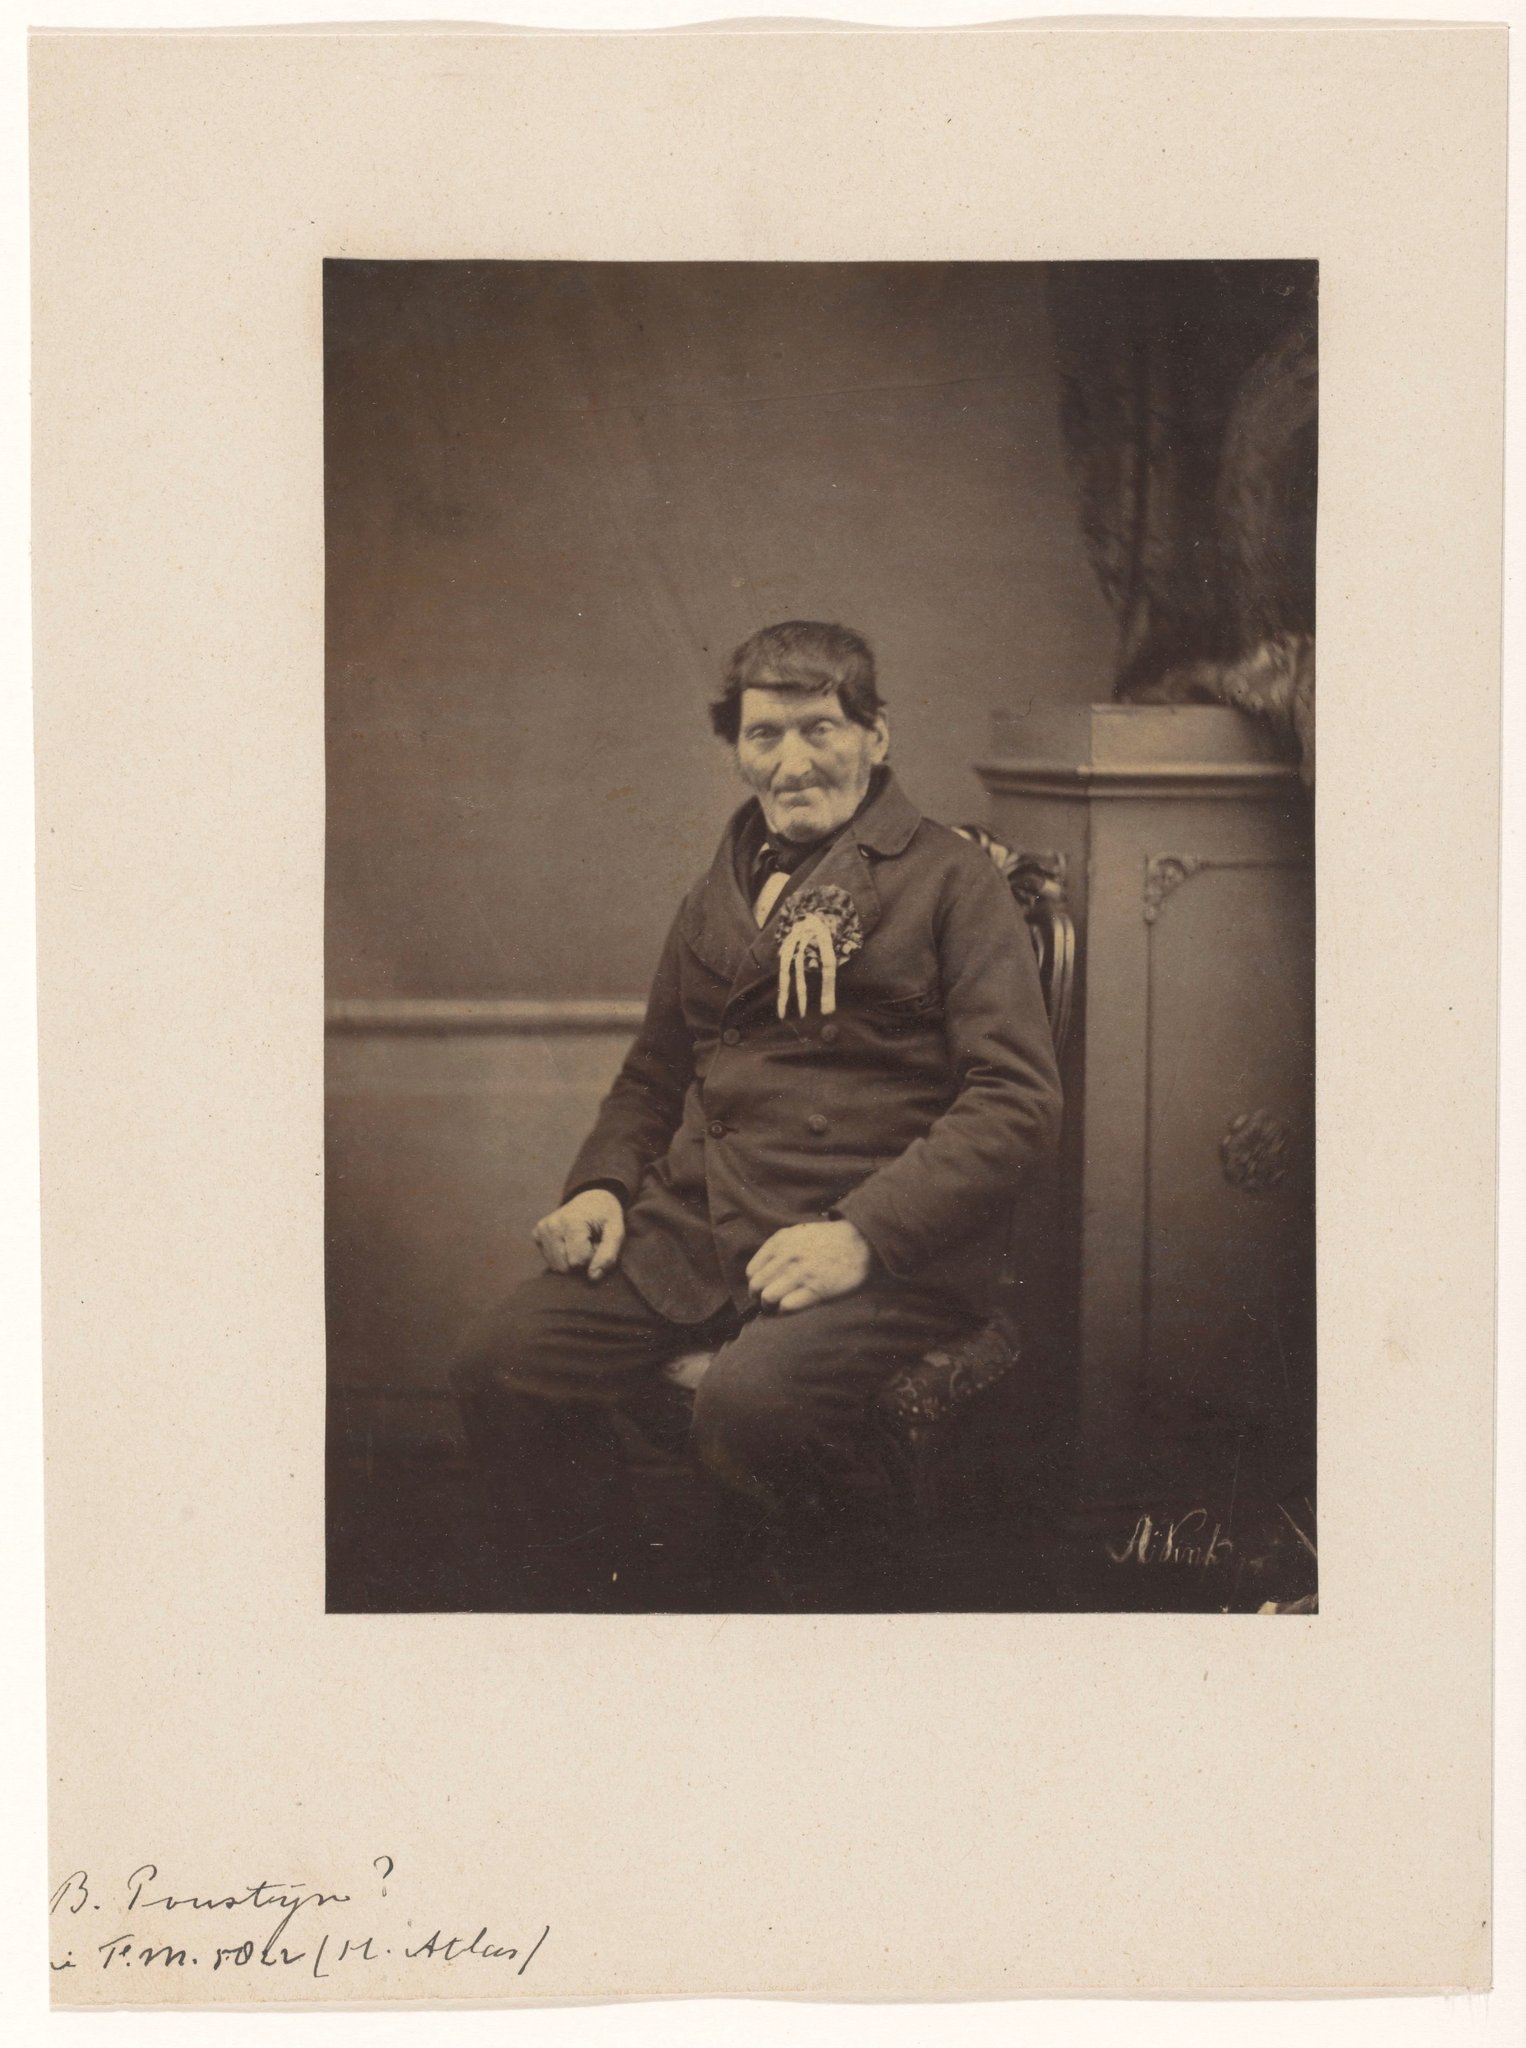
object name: photograph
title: B. Ponstijn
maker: adriaan vink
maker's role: fotograaf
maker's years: 1832-1896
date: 1863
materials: cardboard, paper, photographic support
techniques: albumen print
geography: netherlands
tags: historical persons, crew and passengers ~ ship, amsterdam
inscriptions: annotation: ‘B. Ponstijn?’, name: ‘A. Vink’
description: Bij de herdenking van het feit dat Barend Ponstijn op 15 november 1813 een Oranjevlag plaatste op de Nieuwebrug te Amsterdam, aan het einde van de Franse tijd